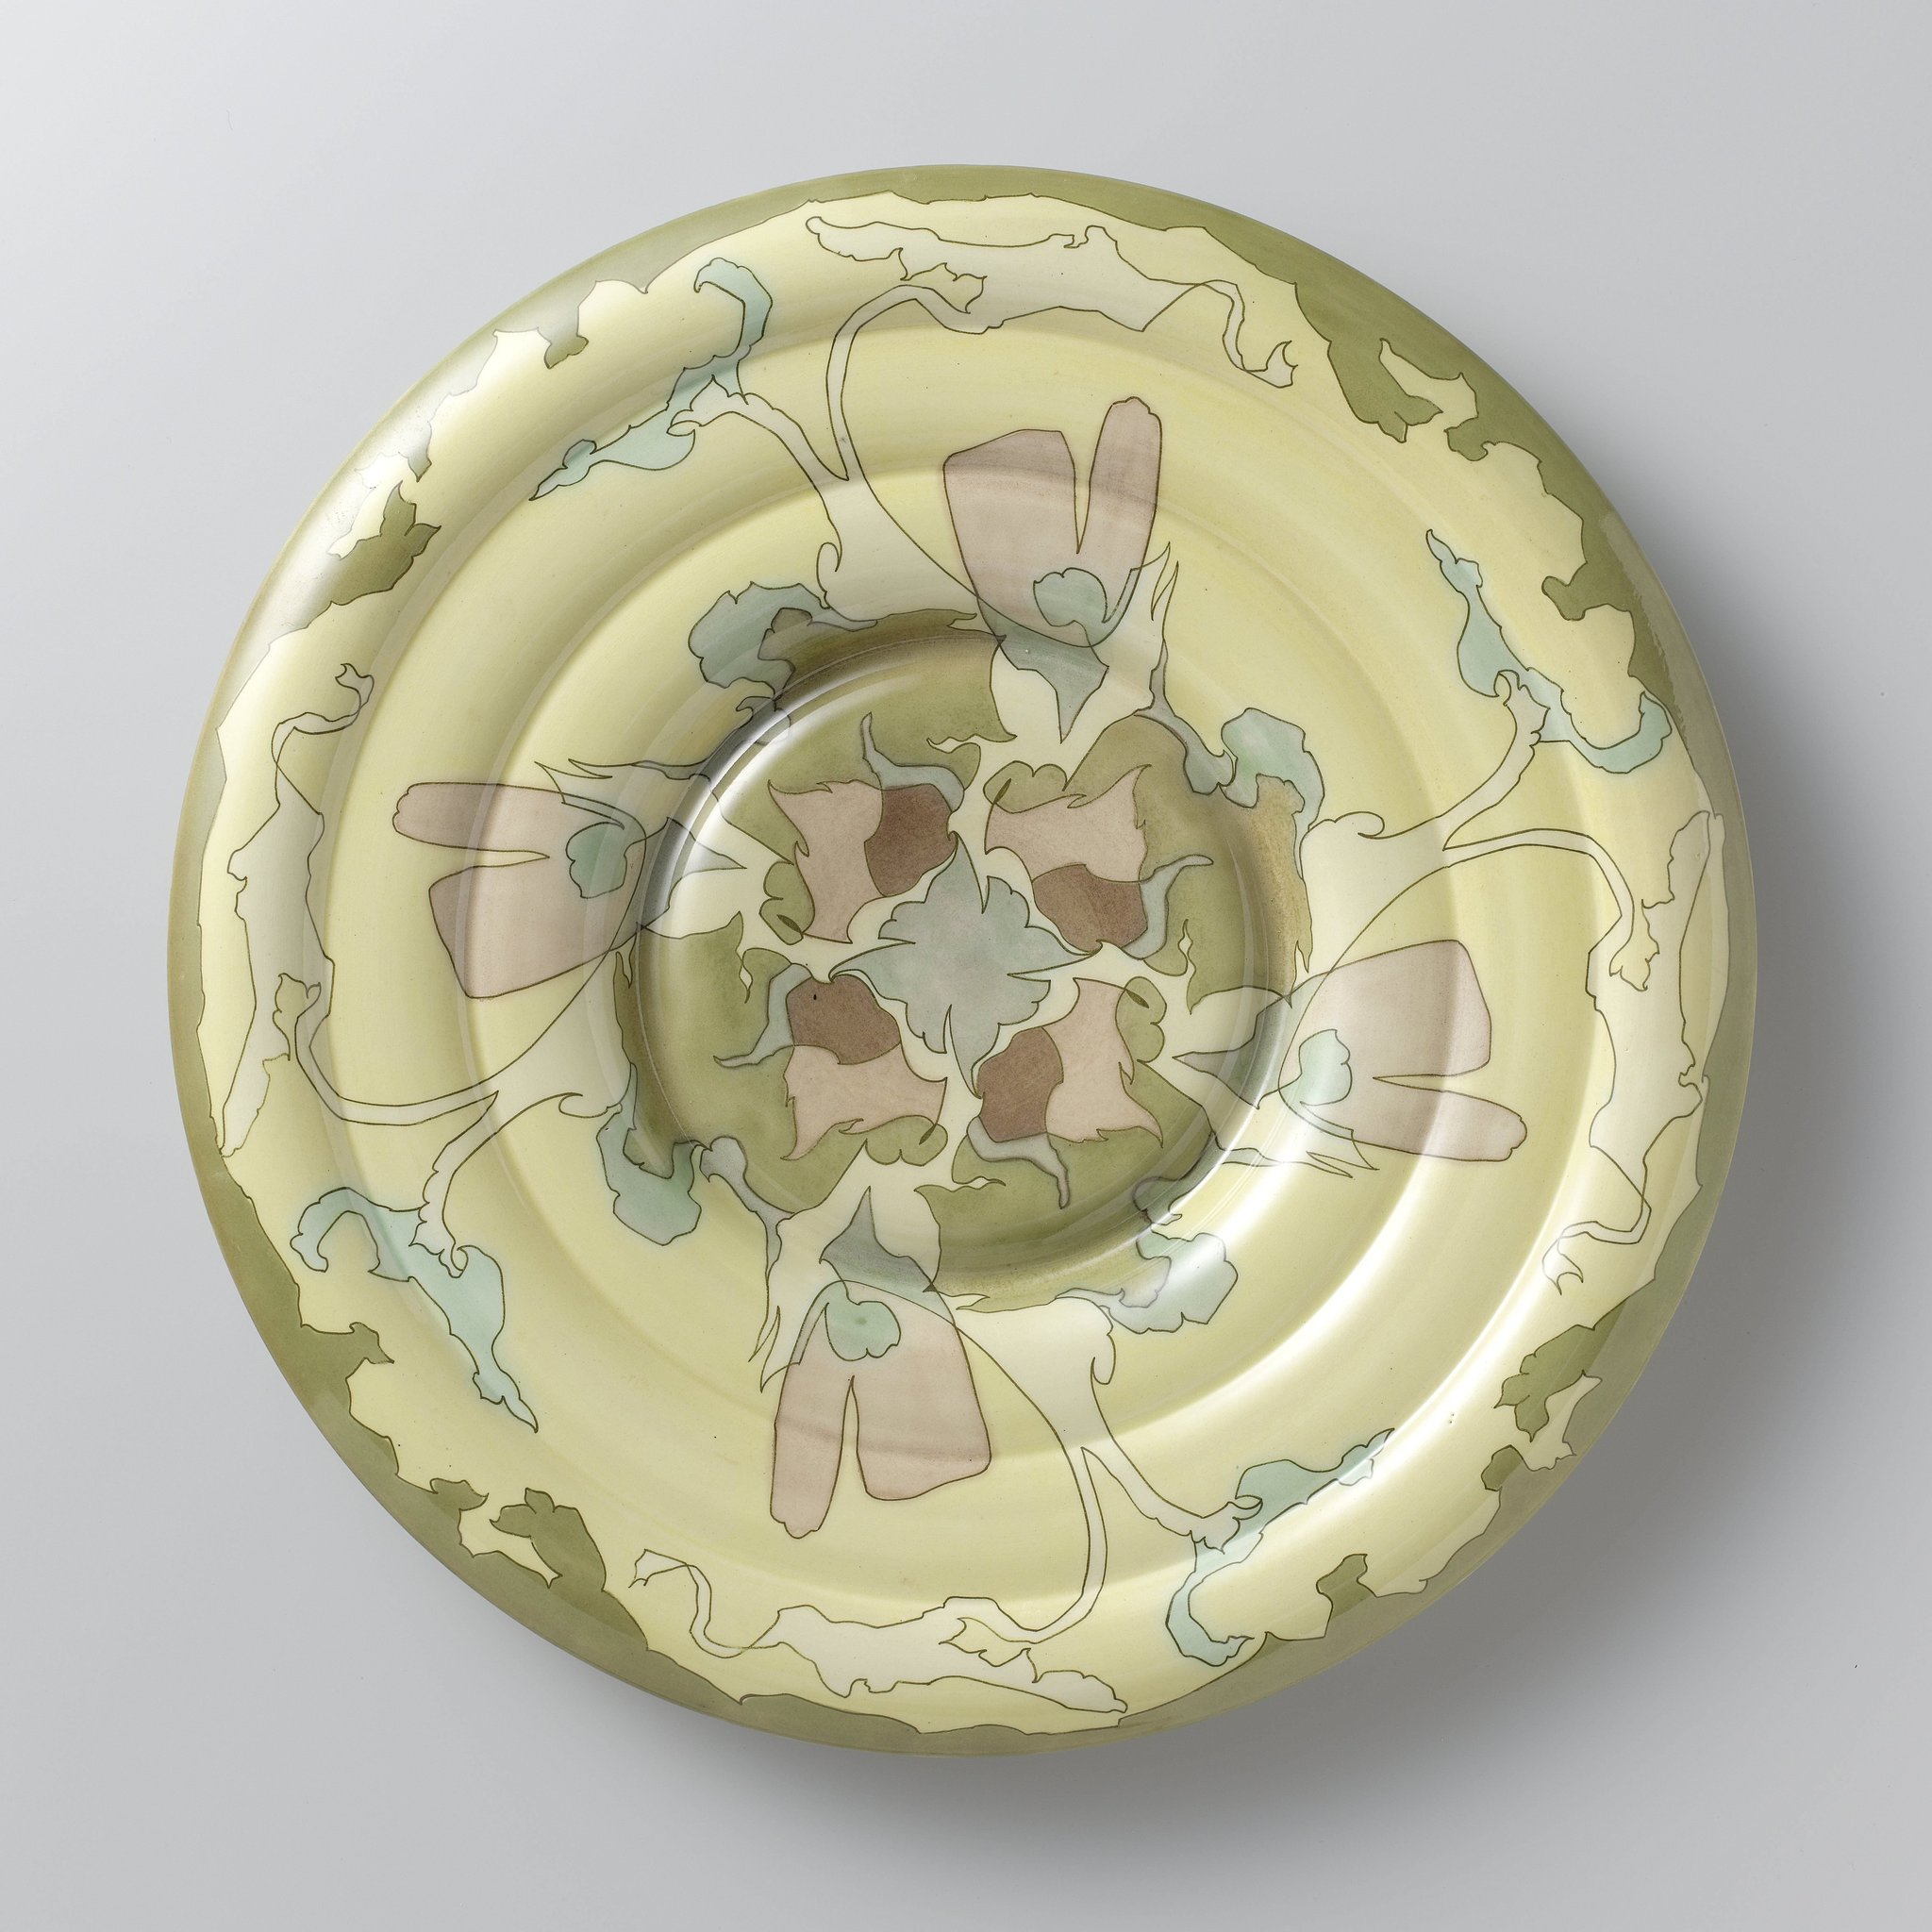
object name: platter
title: Schotel, geribd, met vegetatieve ornamenten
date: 1925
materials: earthenware, chemical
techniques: painted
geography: arnhem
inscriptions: mark: ‘Gestempeld: Colenbrander "Ram" Arnhem Holland, rondom ramskop, en 95 ; monogram (geschilderd in zwart)’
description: Schotel van aardewerk, geribd, polychroom beschilderd met abstracte vegetatieve ornamenten in de kleuren geel, groen, groenblauw, rose en paars op gele fond.